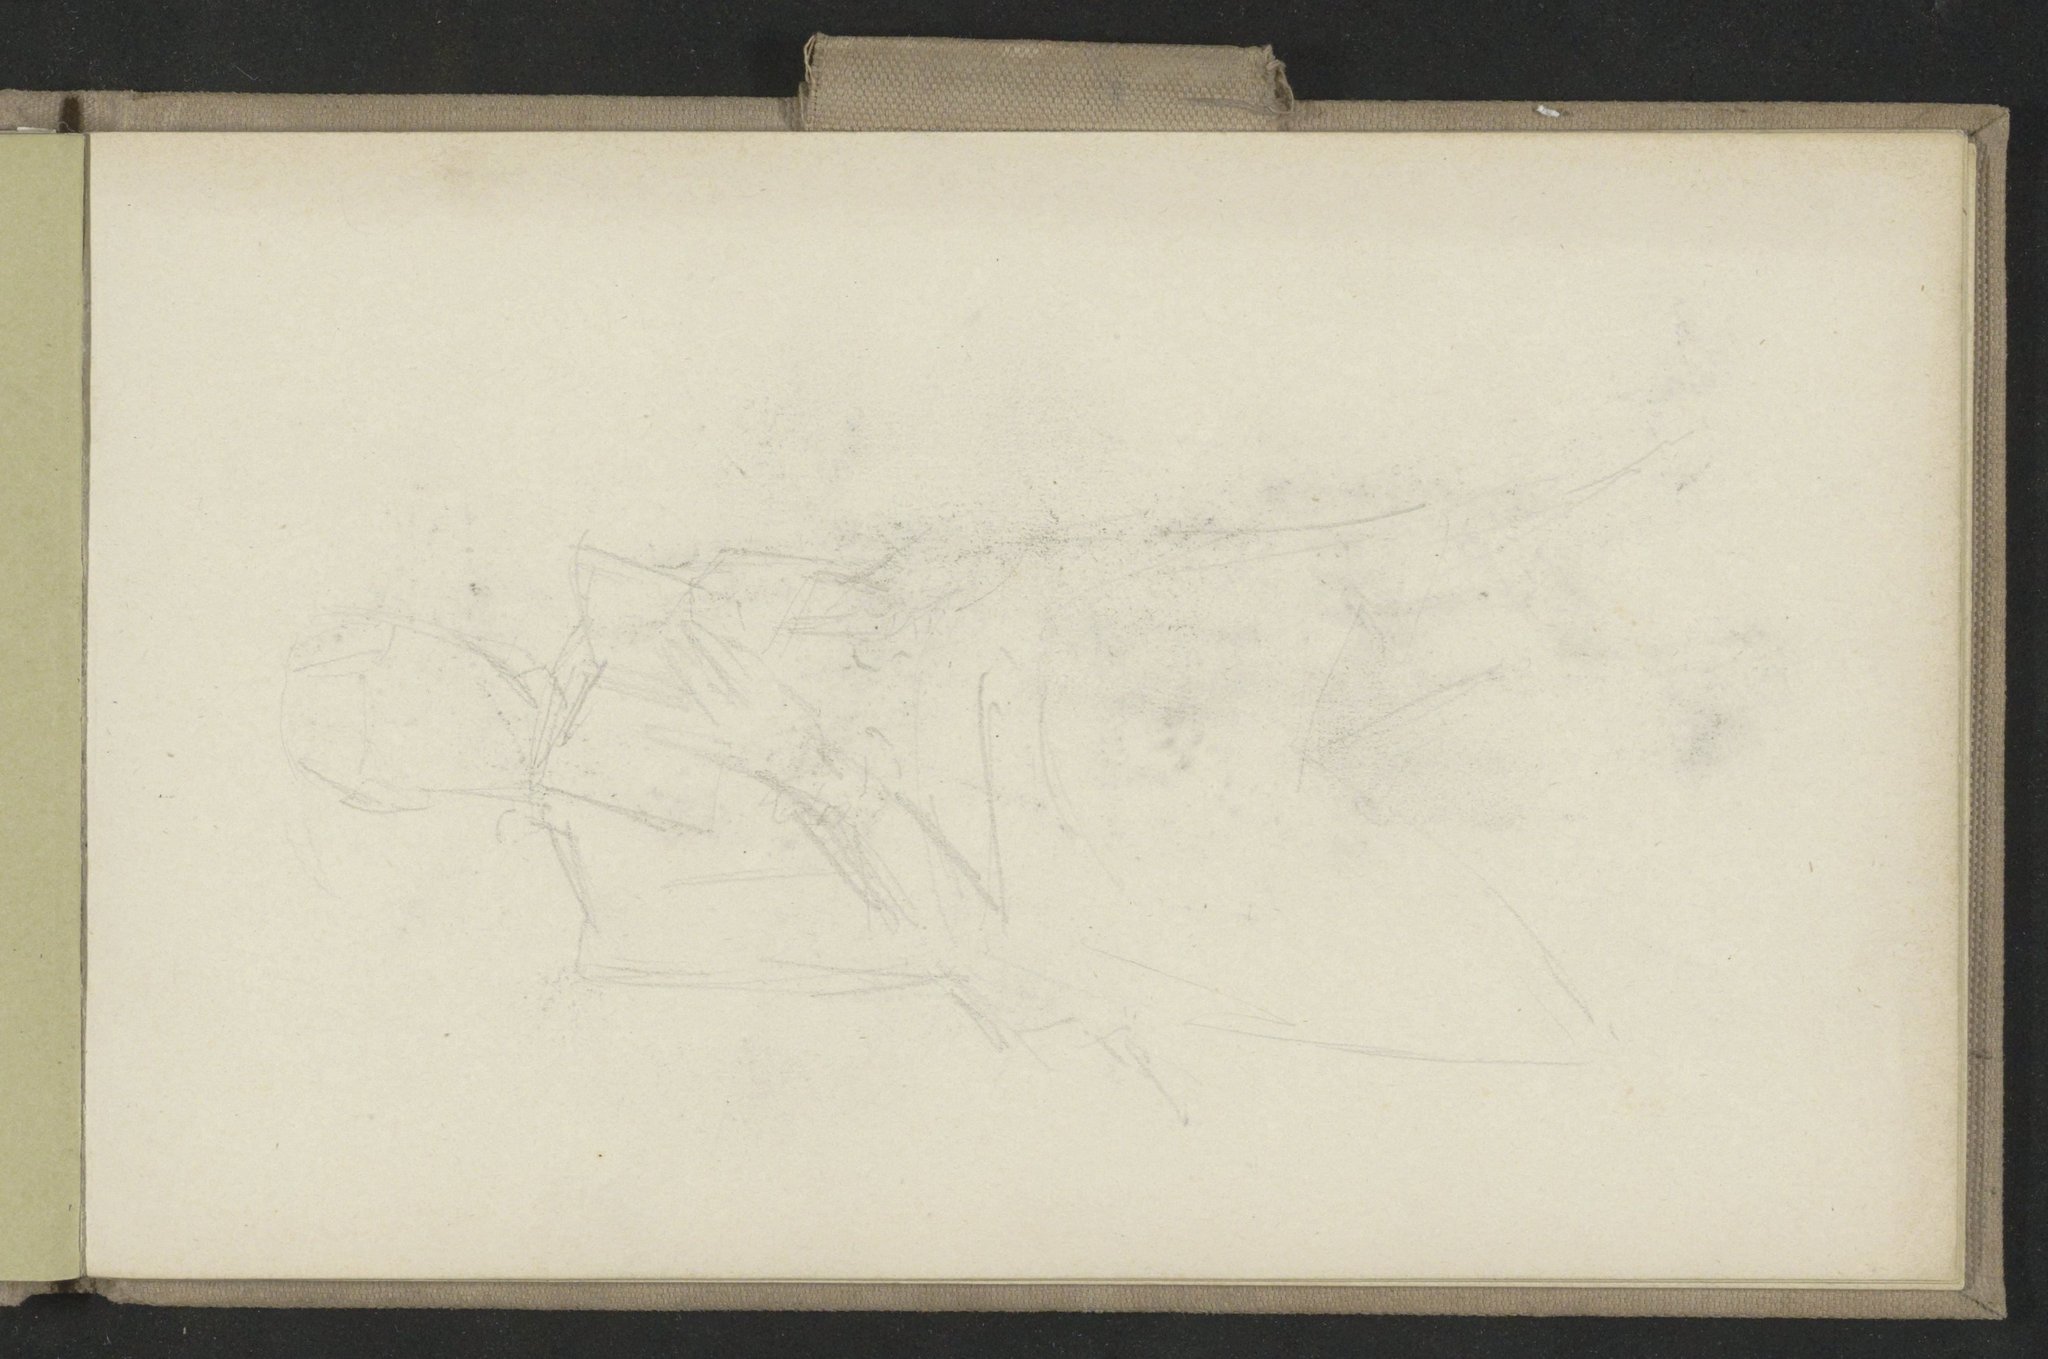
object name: sketchbook leaf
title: Zittende lezende vrouw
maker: jozef israëls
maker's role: draughtsman, painter, print maker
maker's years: 1824-1911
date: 1834-1911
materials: paper, pencil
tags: reading, sitting figure - aa - female human figure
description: Blad 19 recto uit een schetsboek met 26 bladen.